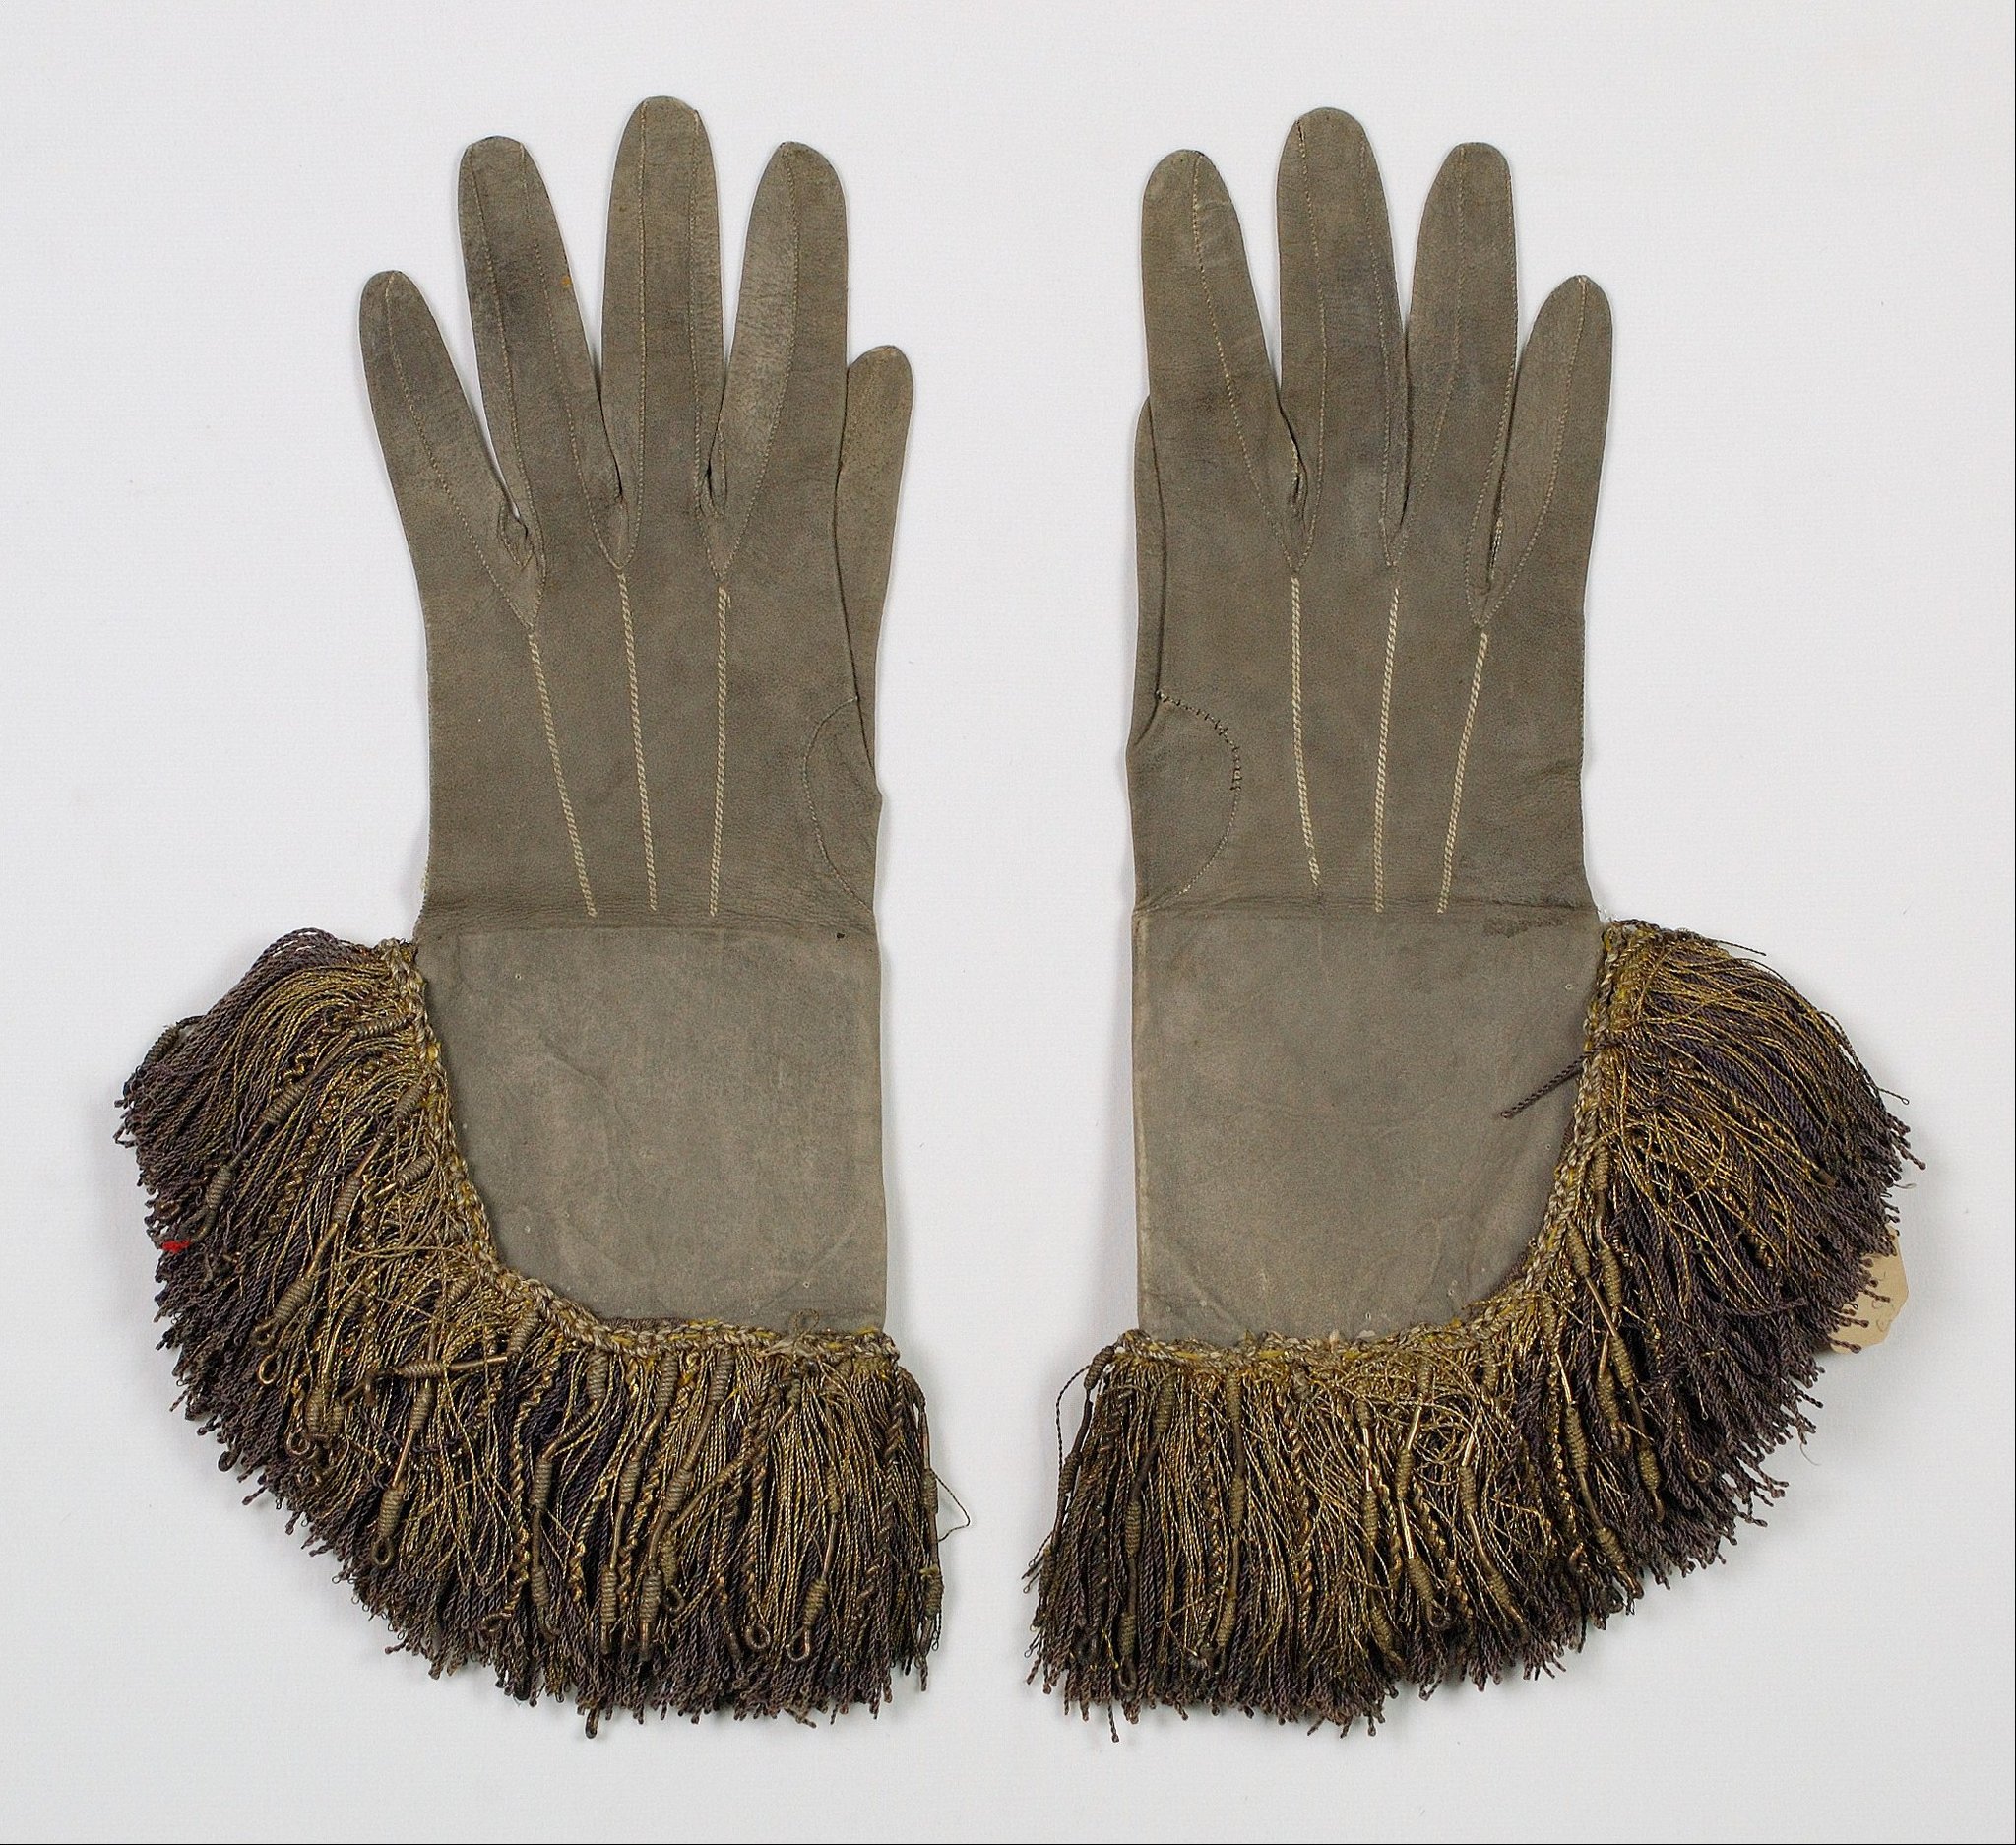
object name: glove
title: Gloves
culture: british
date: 1680-1710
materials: leather, silk